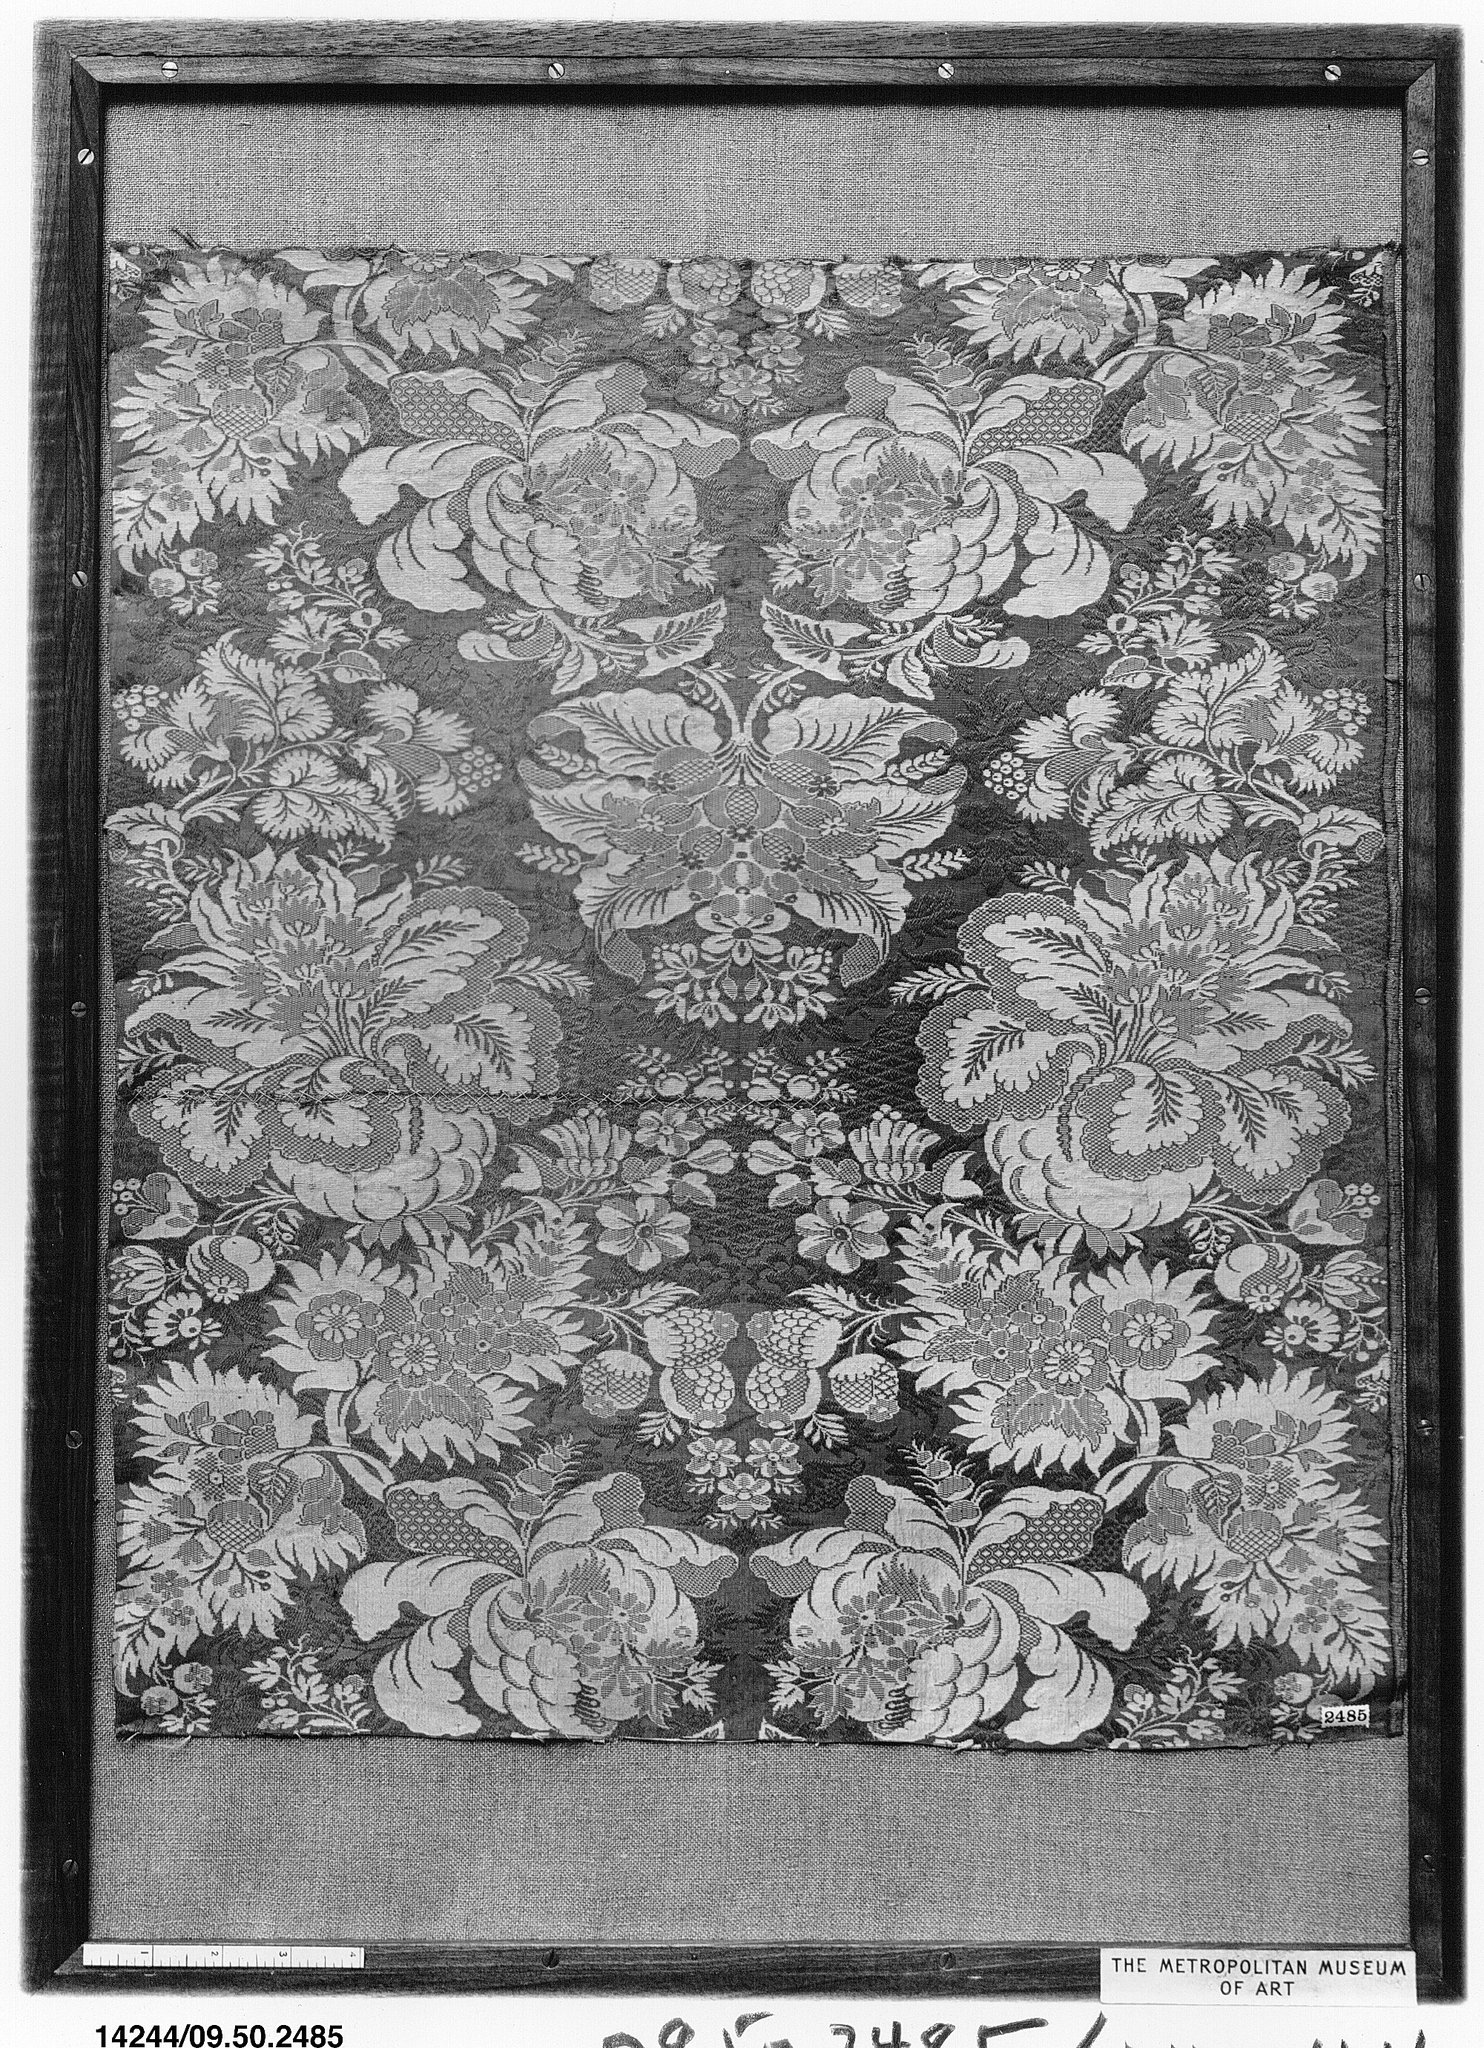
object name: piece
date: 1735-1750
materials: silk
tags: flowers,leaves